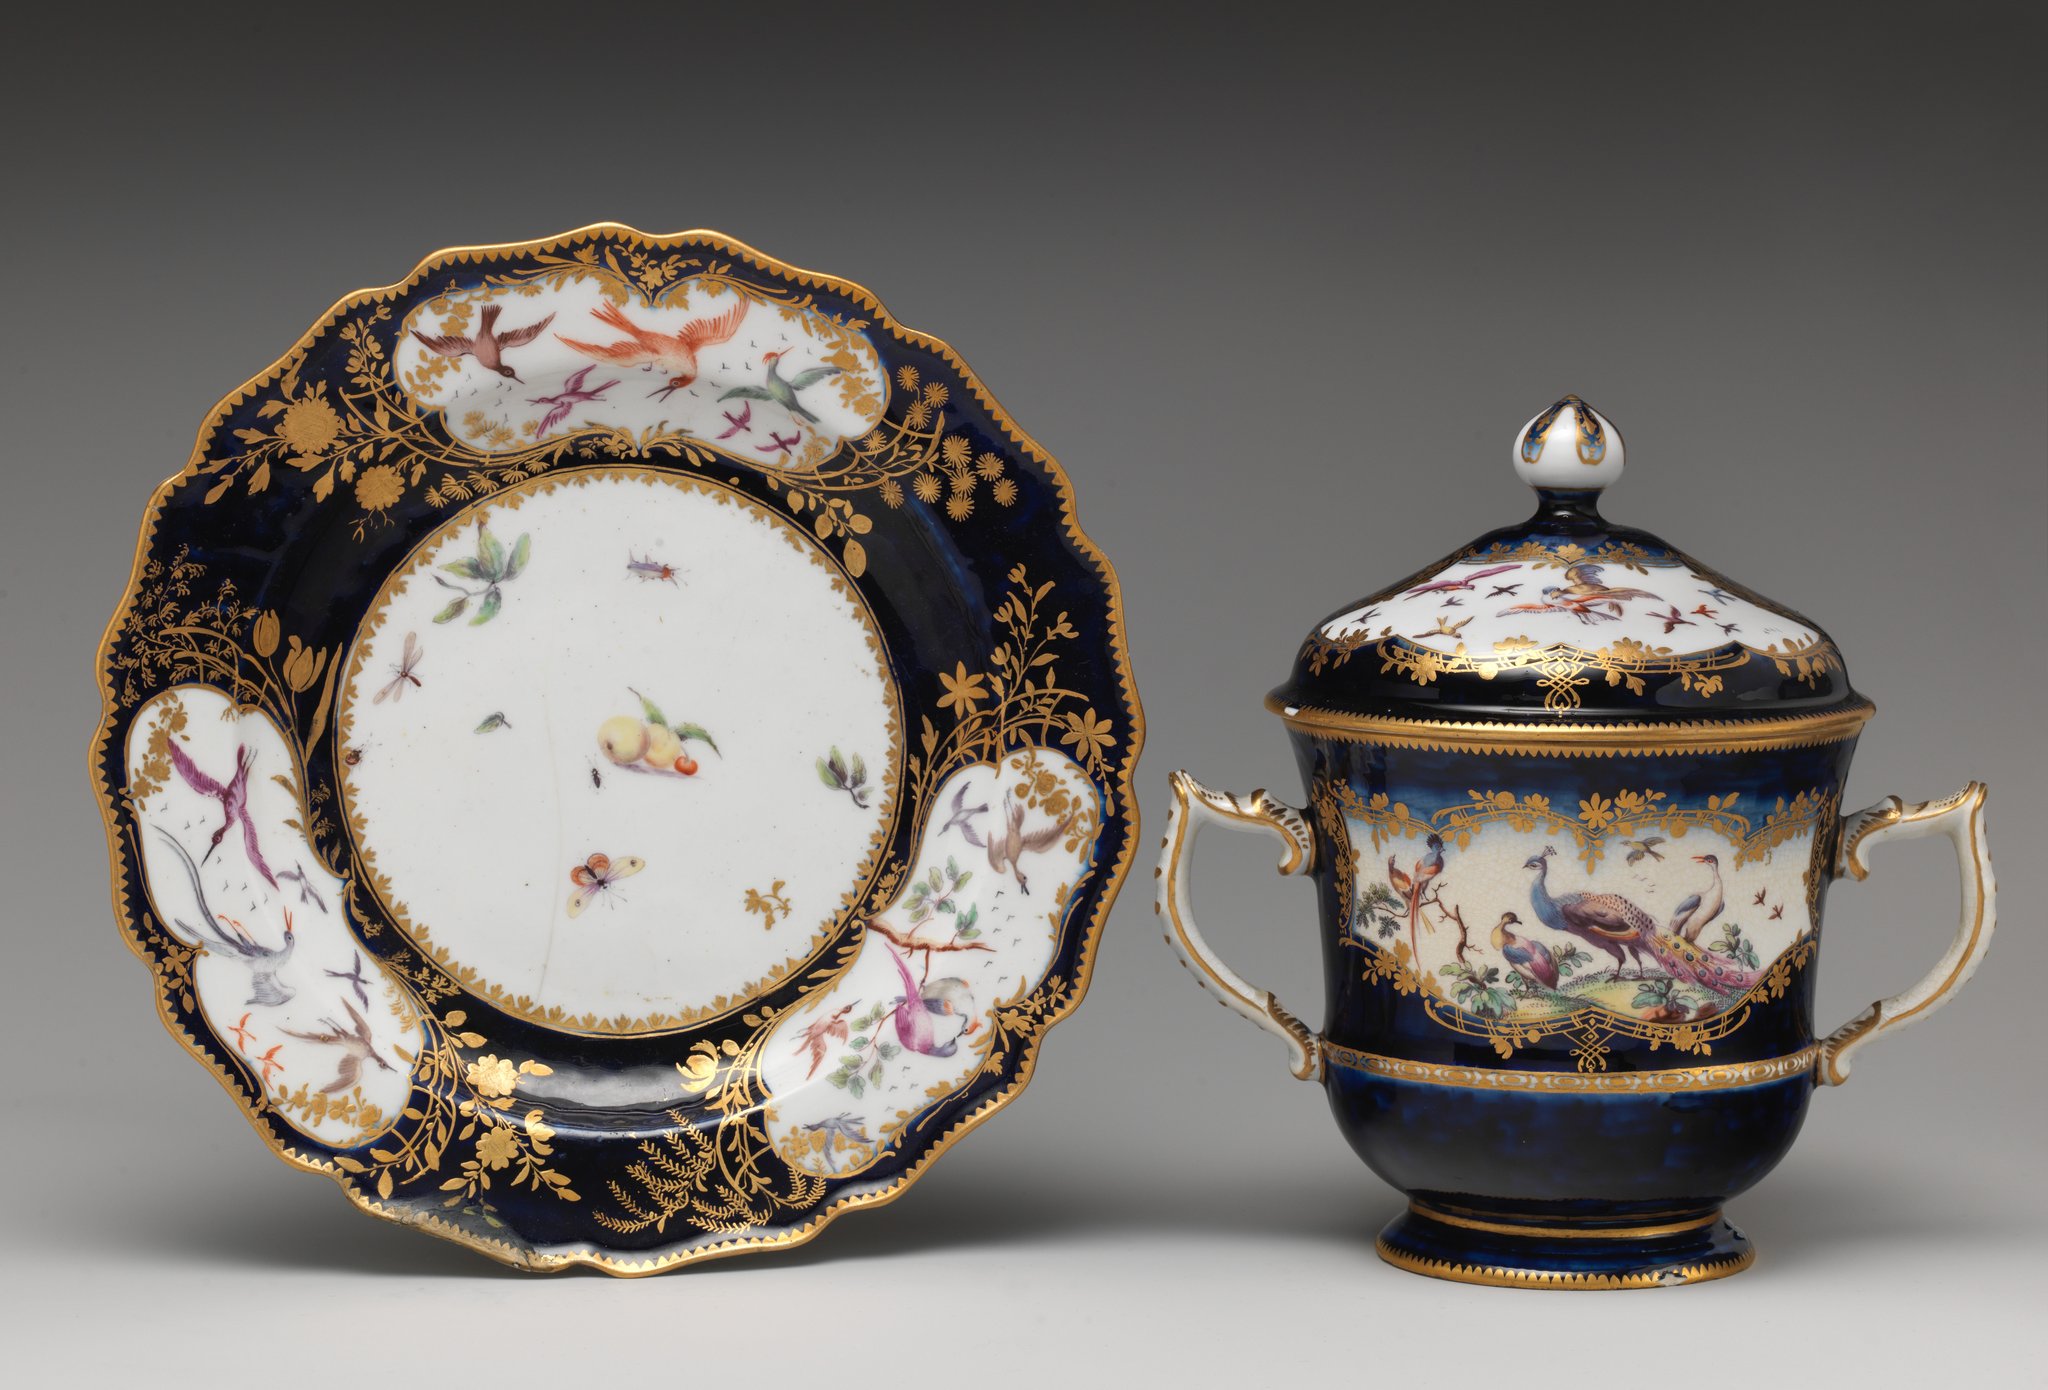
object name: bowl with cover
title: Two-handled bowl with cover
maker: chelsea porcelain manufactory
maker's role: factory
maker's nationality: british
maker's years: 1744-1784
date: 1765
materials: soft paste porcelain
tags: birds,peacocks